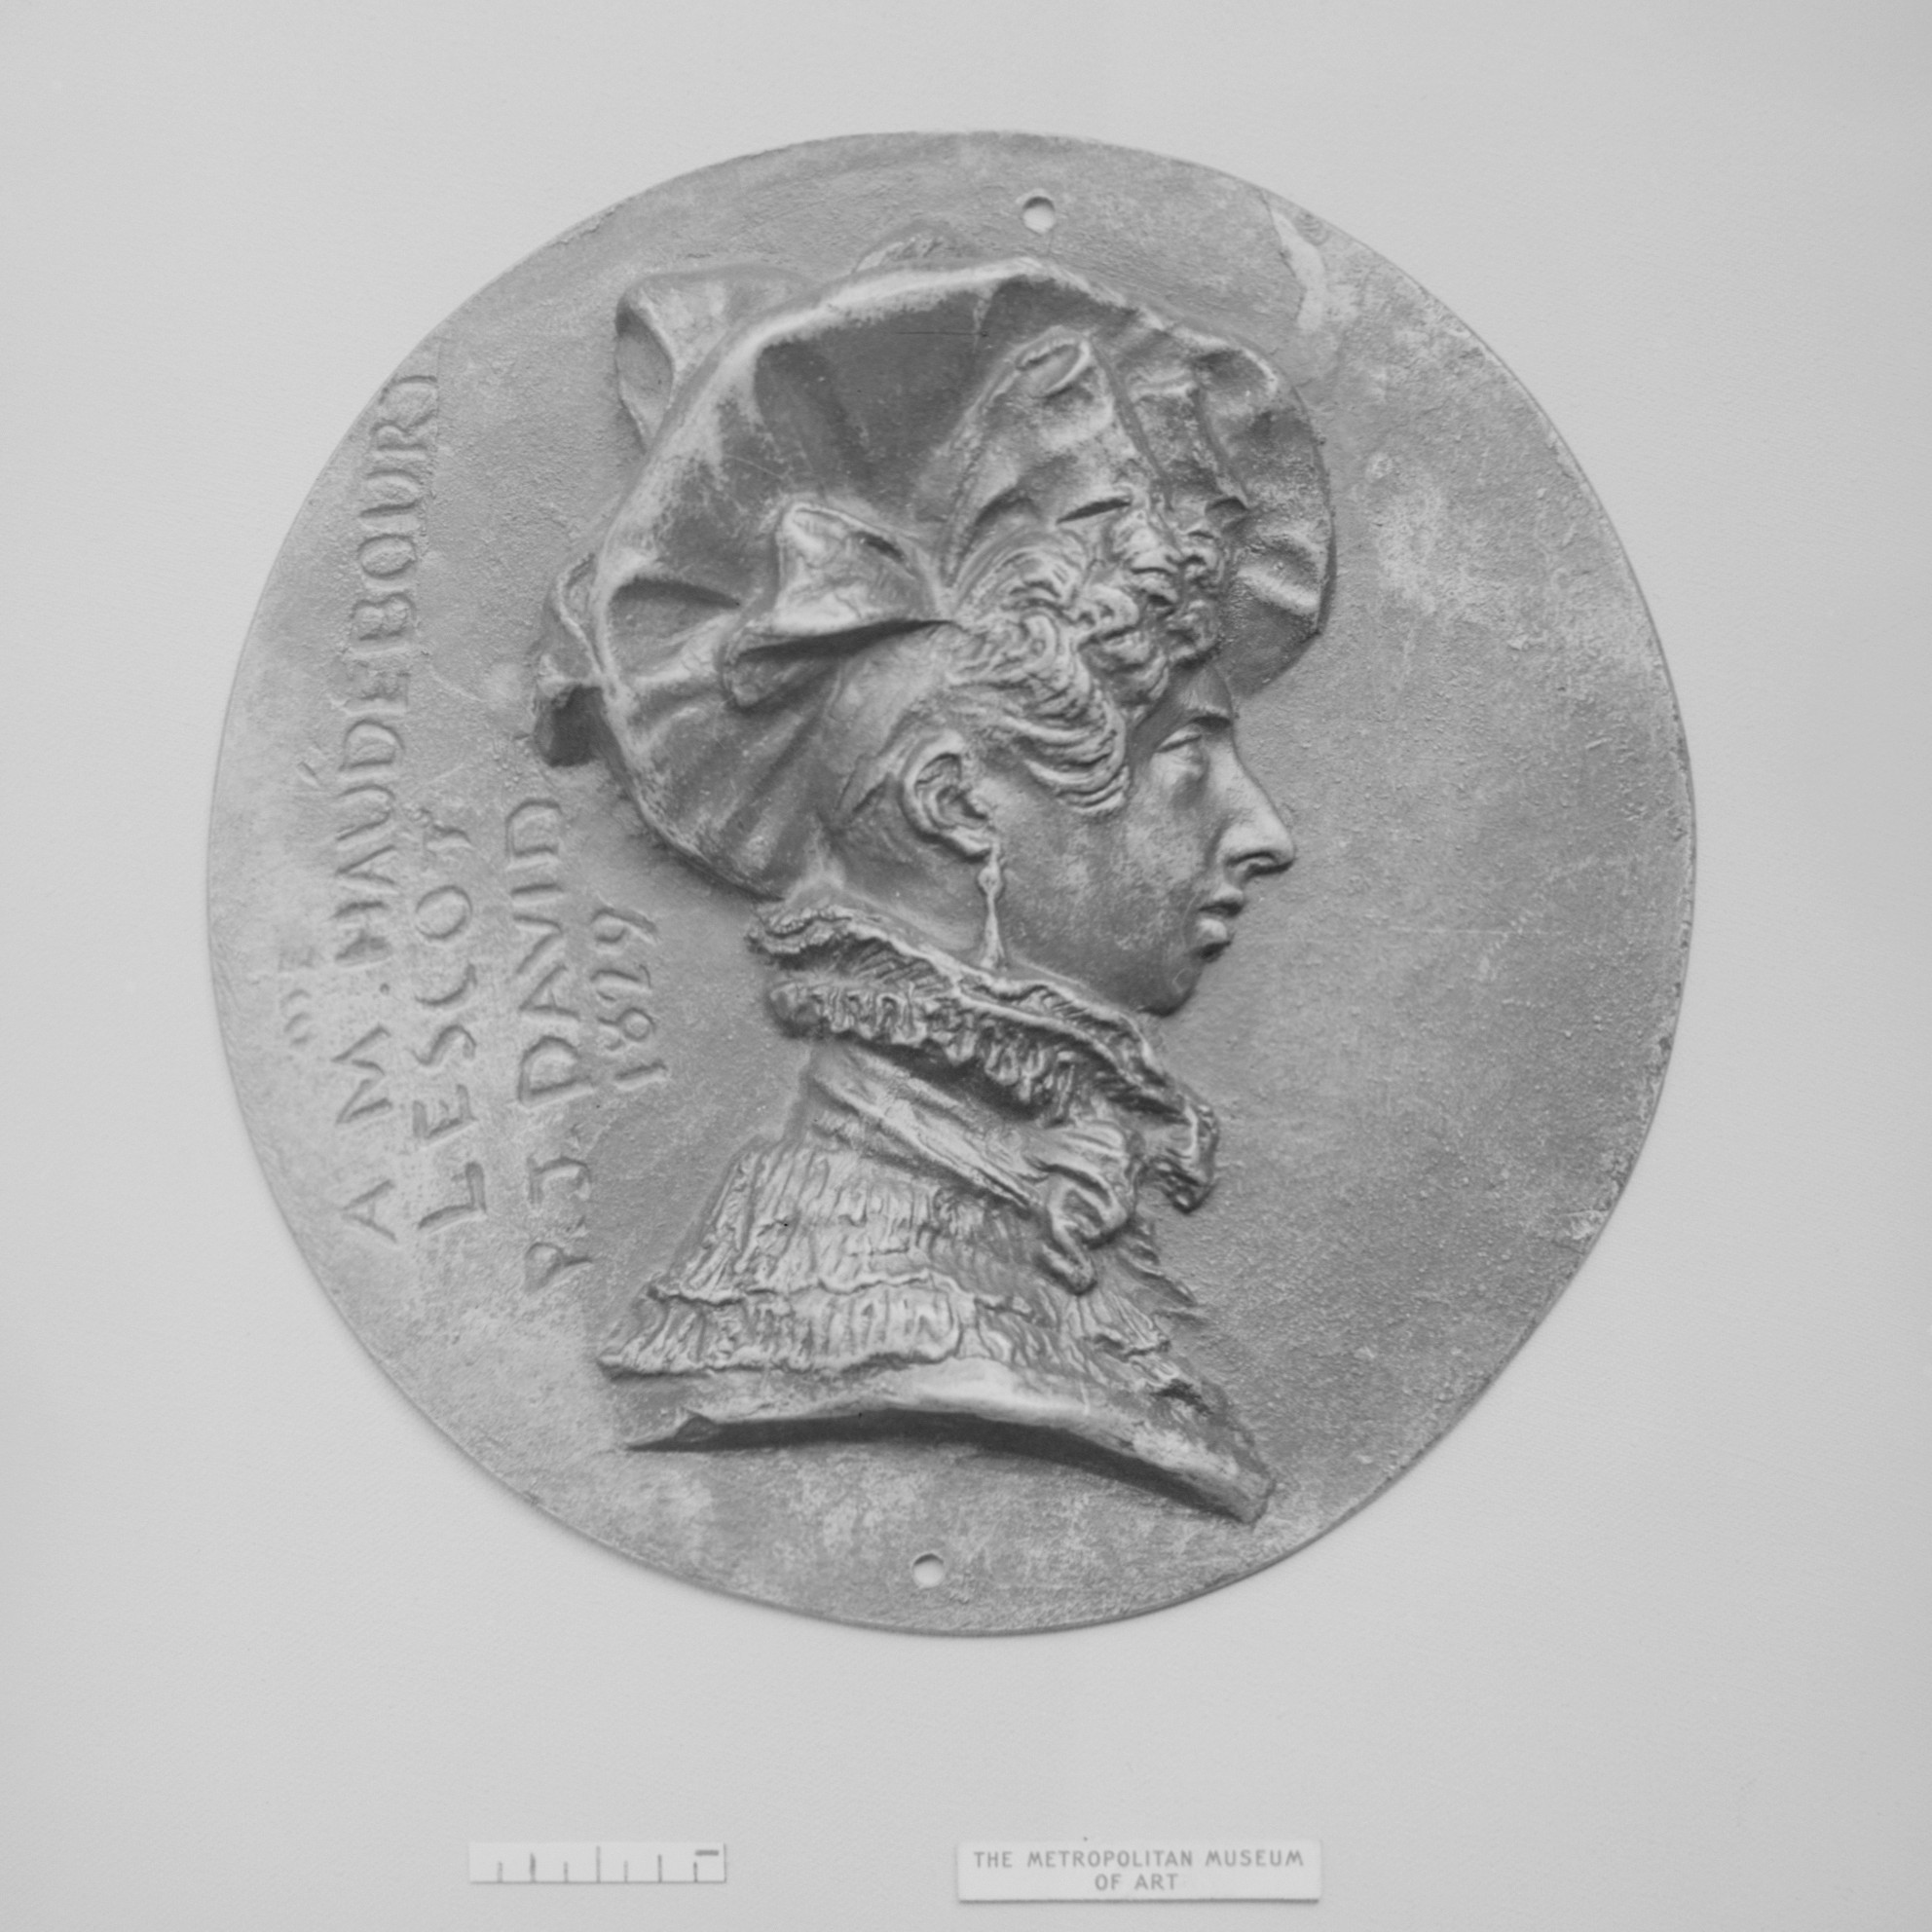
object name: medallion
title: Antoinette Cécile Hortense Lescot, Mme. Haudebourt-Lescot, painter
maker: pierre jean david d'angers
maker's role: artist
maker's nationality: french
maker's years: 1788-1856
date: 1829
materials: bronze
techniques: casting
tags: profiles,women